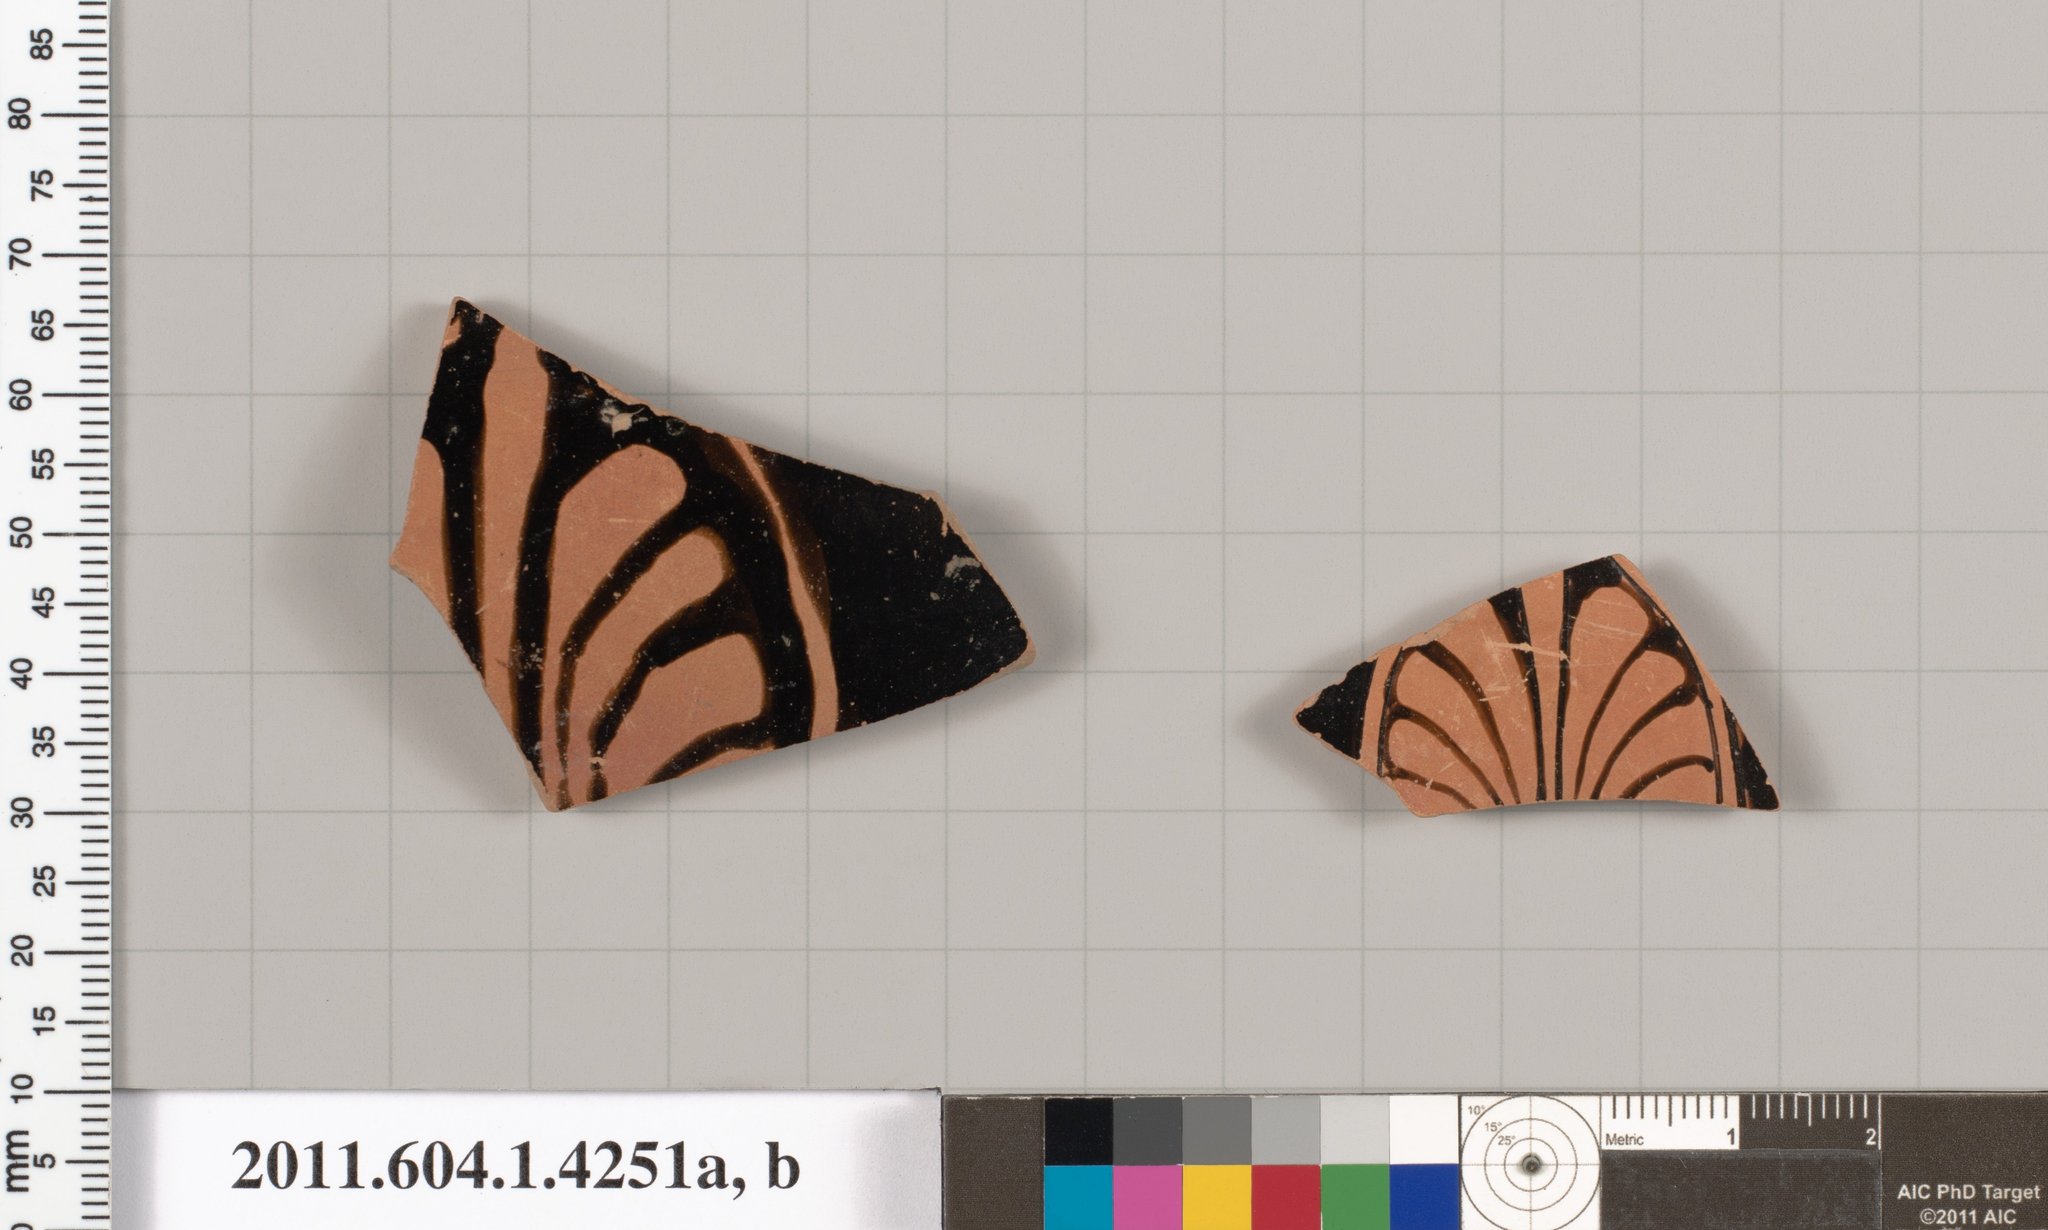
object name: kylix fragment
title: Terracotta fragments of kylikes (drinking cups)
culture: greek, attic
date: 500-451 BCE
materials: terracotta